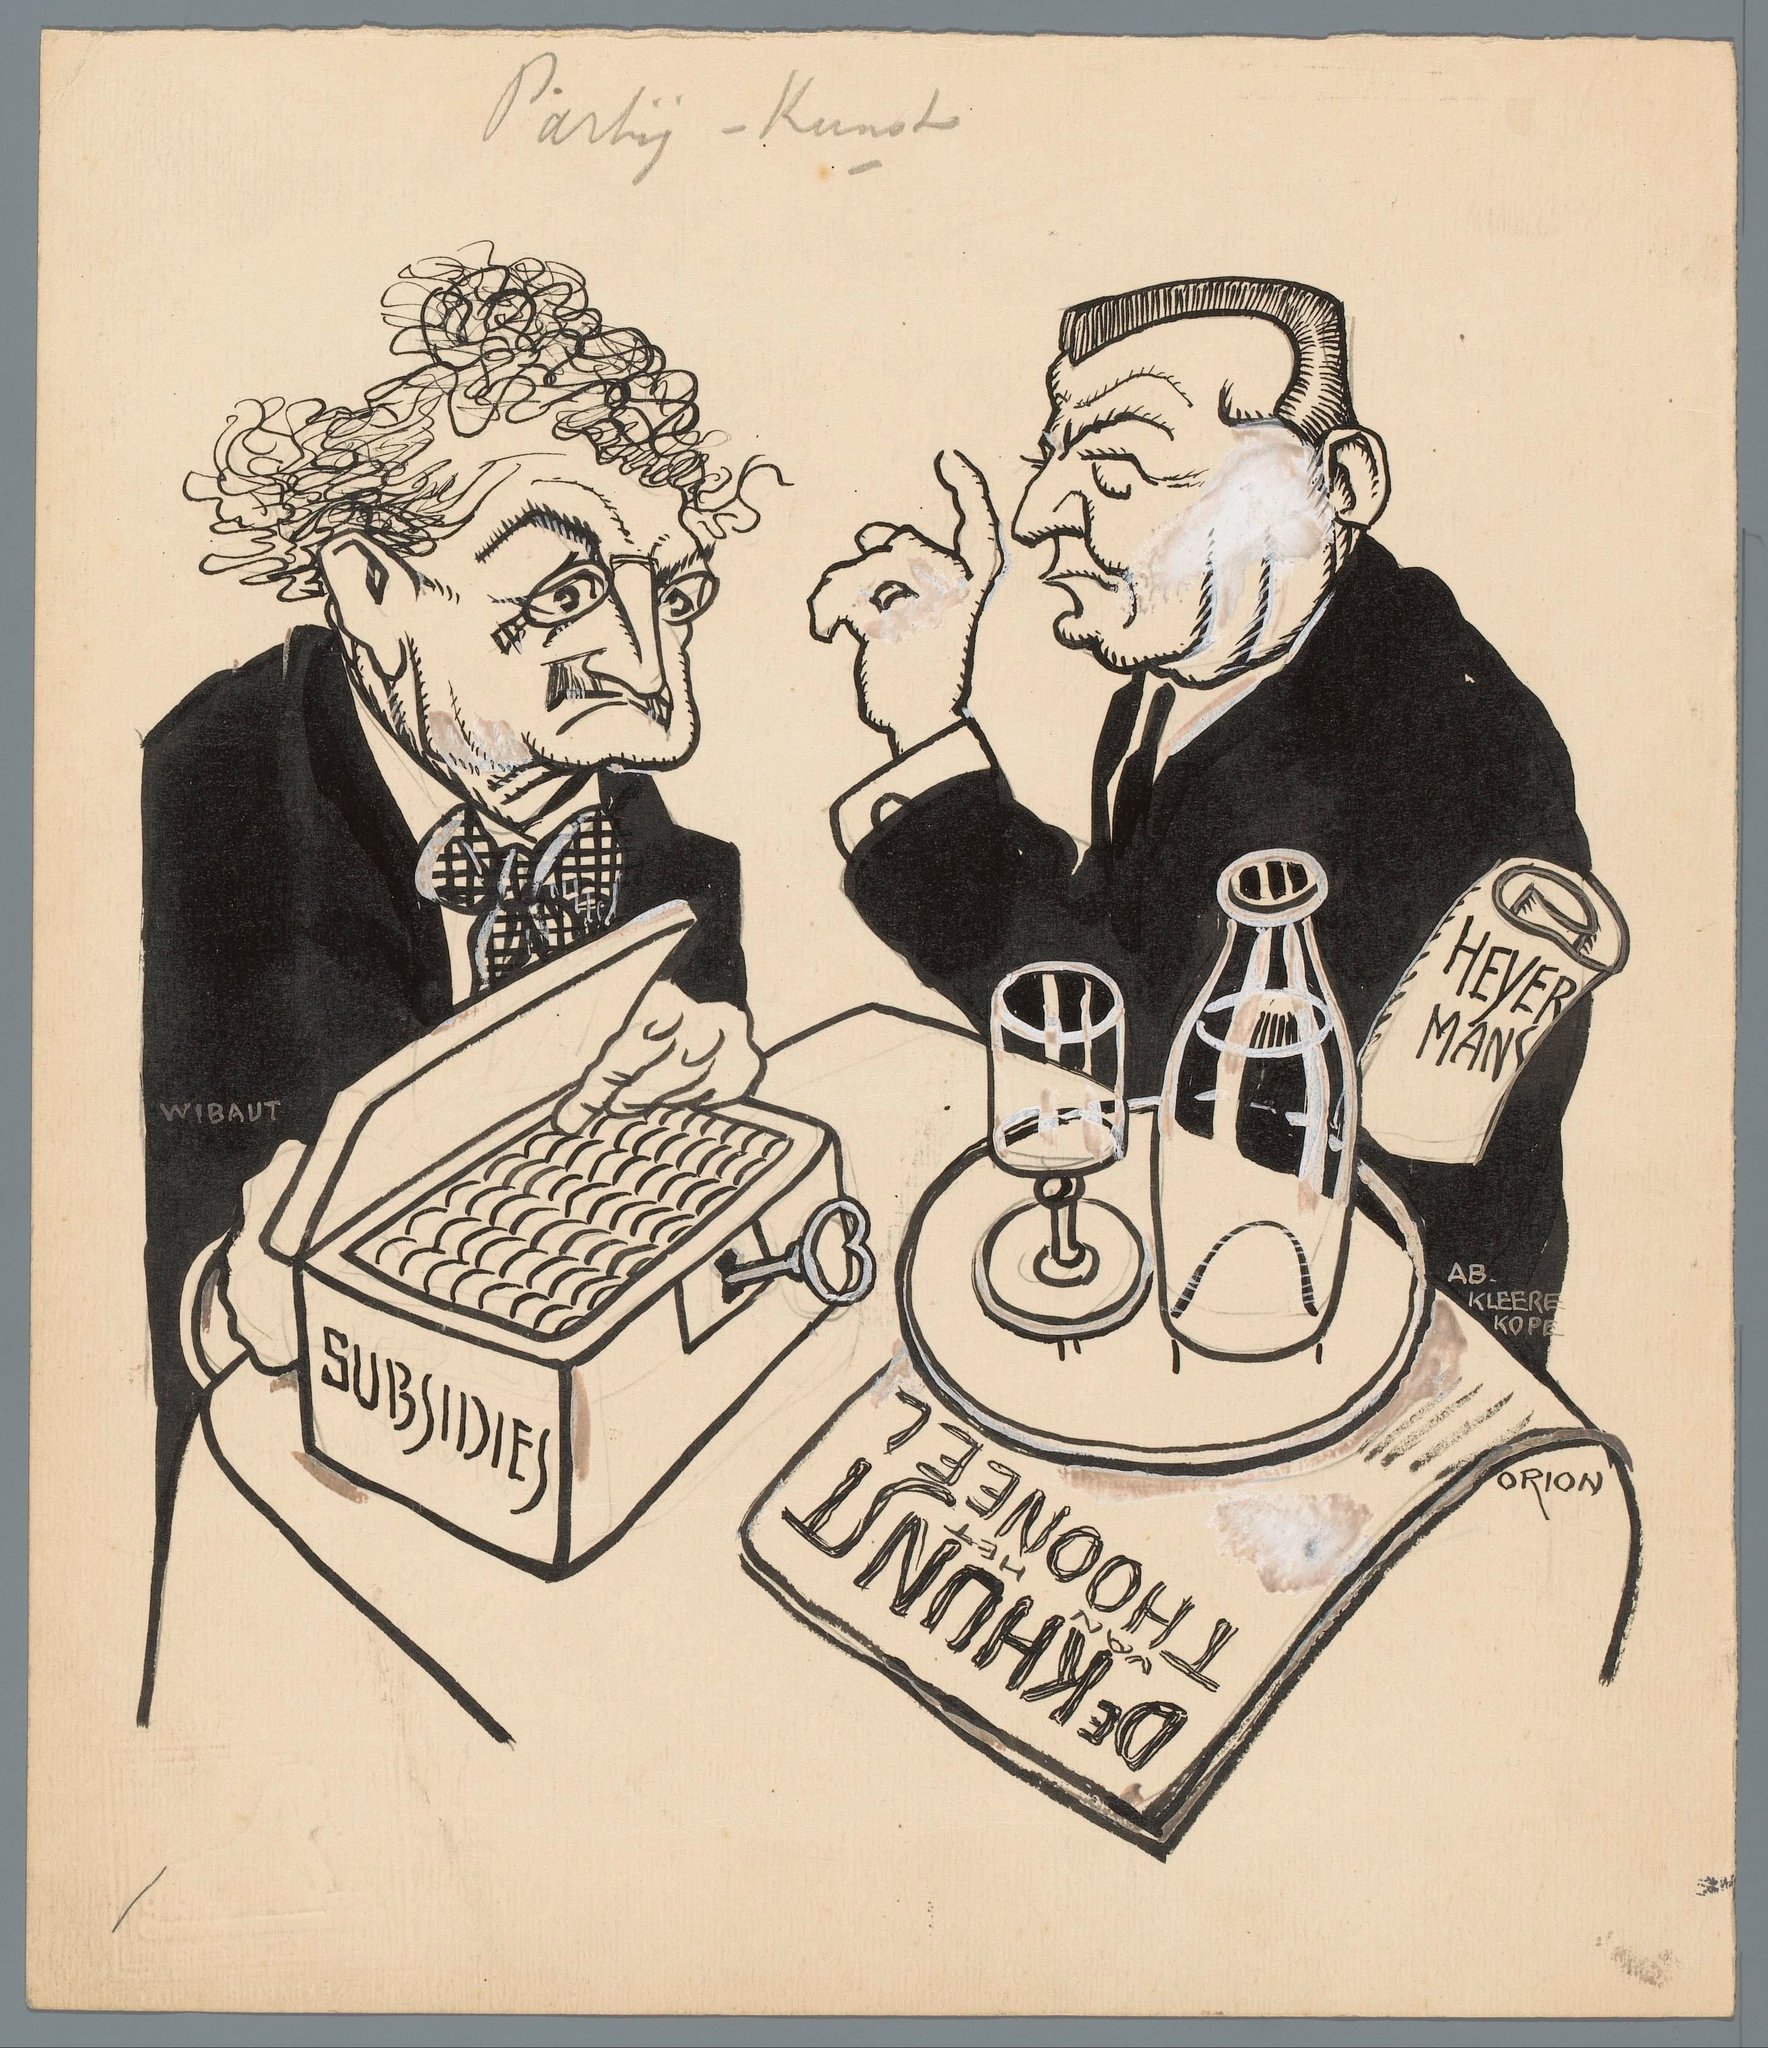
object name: drawing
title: Partij-Kunst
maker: patricq kroon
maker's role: draughtsman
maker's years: 1862-1941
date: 1913-1929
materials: ink, paint, paper, pencil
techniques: brush, pen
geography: netherlands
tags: amsterdam, politician, flushing, the arts; artists, political caricatures and satires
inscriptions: inscription: ‘Partij-Kunst’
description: Wibaut en Kleerekoper en de subsidies voor de kunsten en toneel. Ontwerp voor een politieke spotprent.